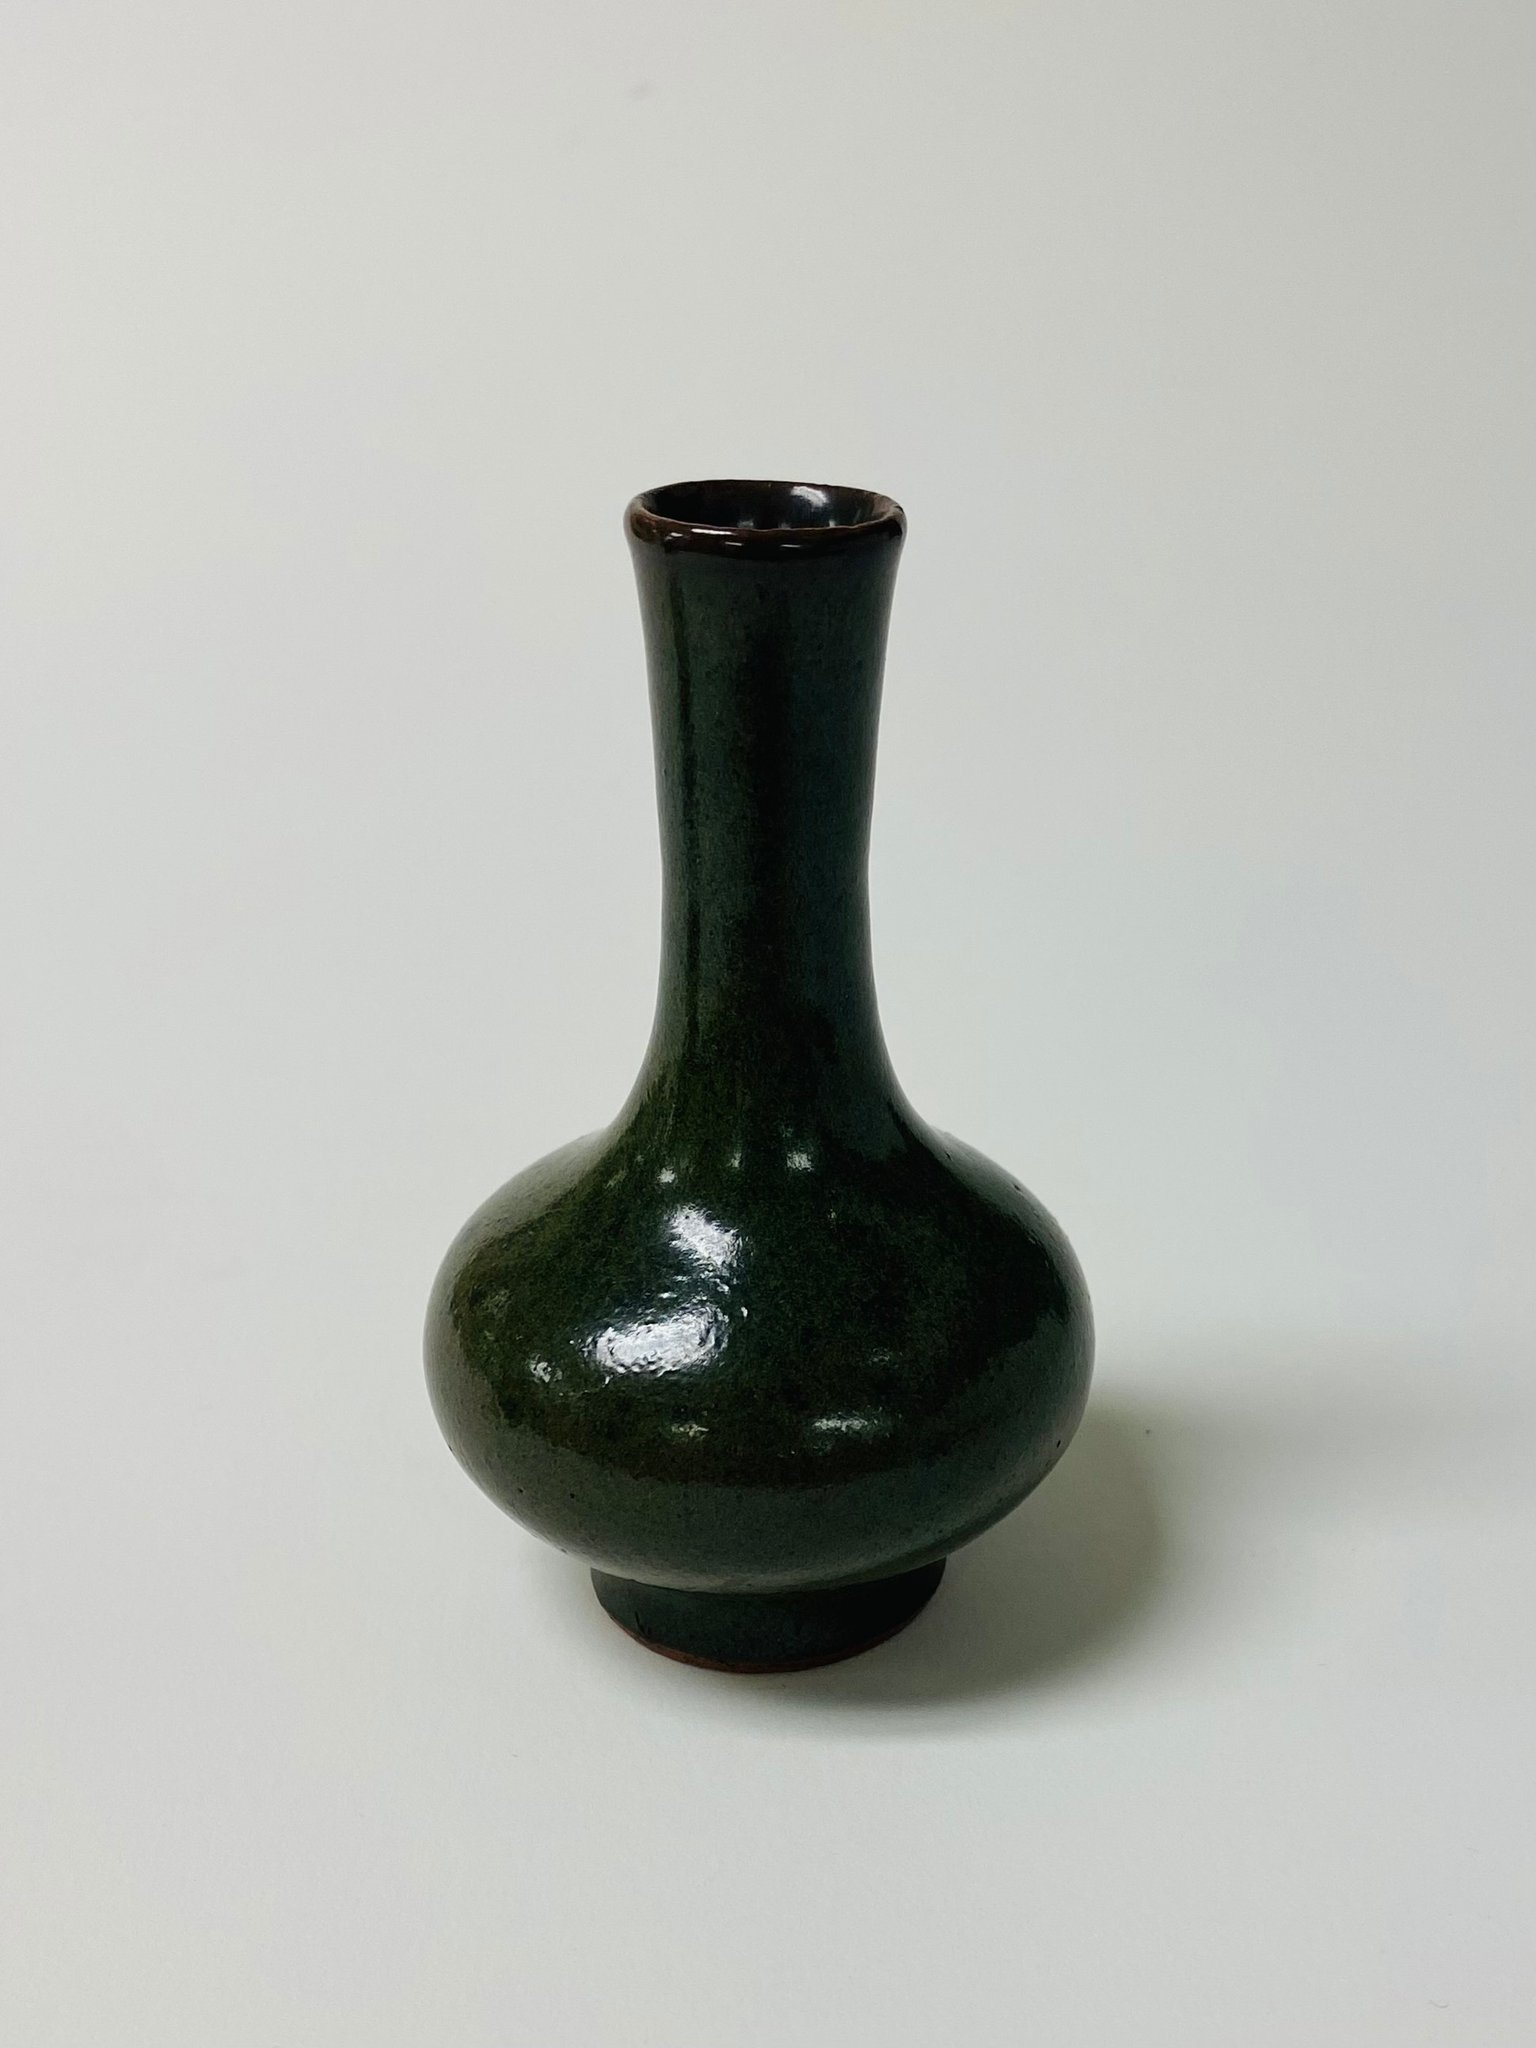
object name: bottle vase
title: Minature bottle vase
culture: chinese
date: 1801-1900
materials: glaze, porcelain